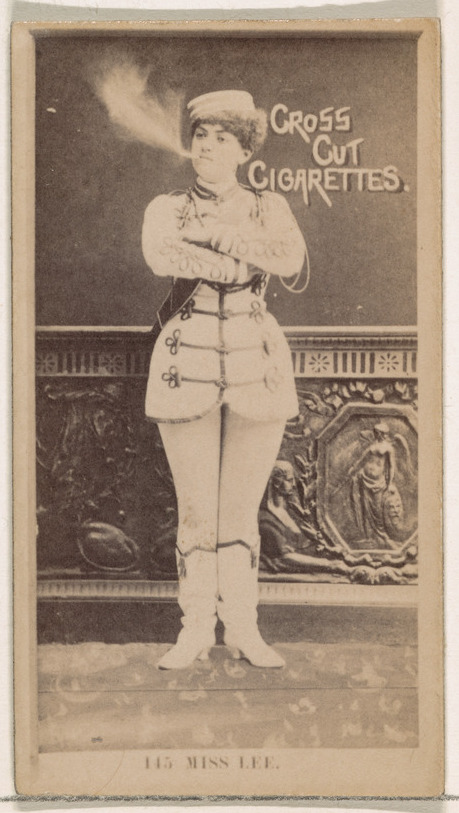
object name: print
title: Card Number 145, Miss Lee, from the Actors and Actresses series (N145-2) issued by Duke Sons & Co. to promote Cross Cut Cigarettes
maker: w. duke, sons & co.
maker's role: publisher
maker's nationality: american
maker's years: 1870-1920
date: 1880-1889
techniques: albumen silver print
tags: portraits,women,actresses